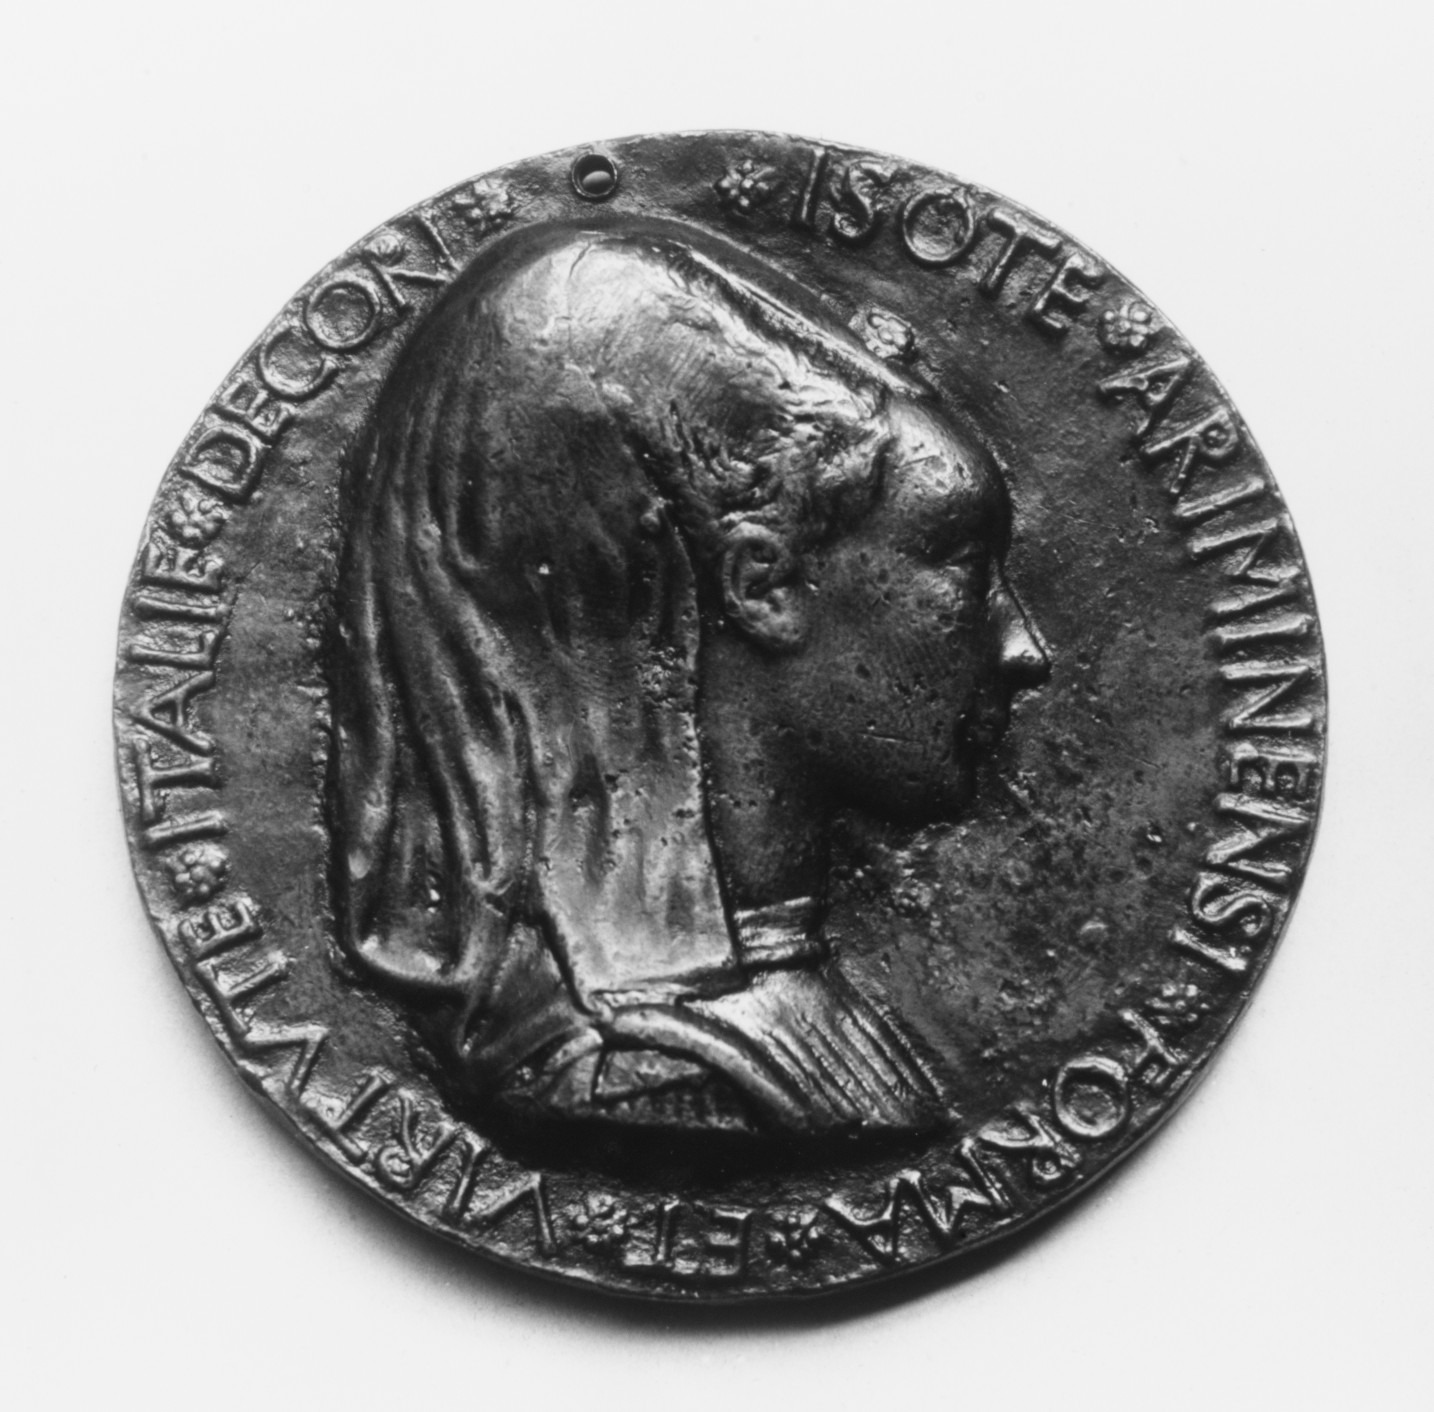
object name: medal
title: Isotta degli Atti of Rimini, d. 1470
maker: matteo de' pasti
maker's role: artist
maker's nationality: italian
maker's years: 1420-1467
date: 1446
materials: bronze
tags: profiles,women,elephants